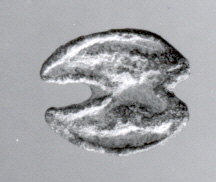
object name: stamp seal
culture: bactria-margiana archaeological complex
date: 2333-1668 BCE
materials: copper alloy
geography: bactria-margiana